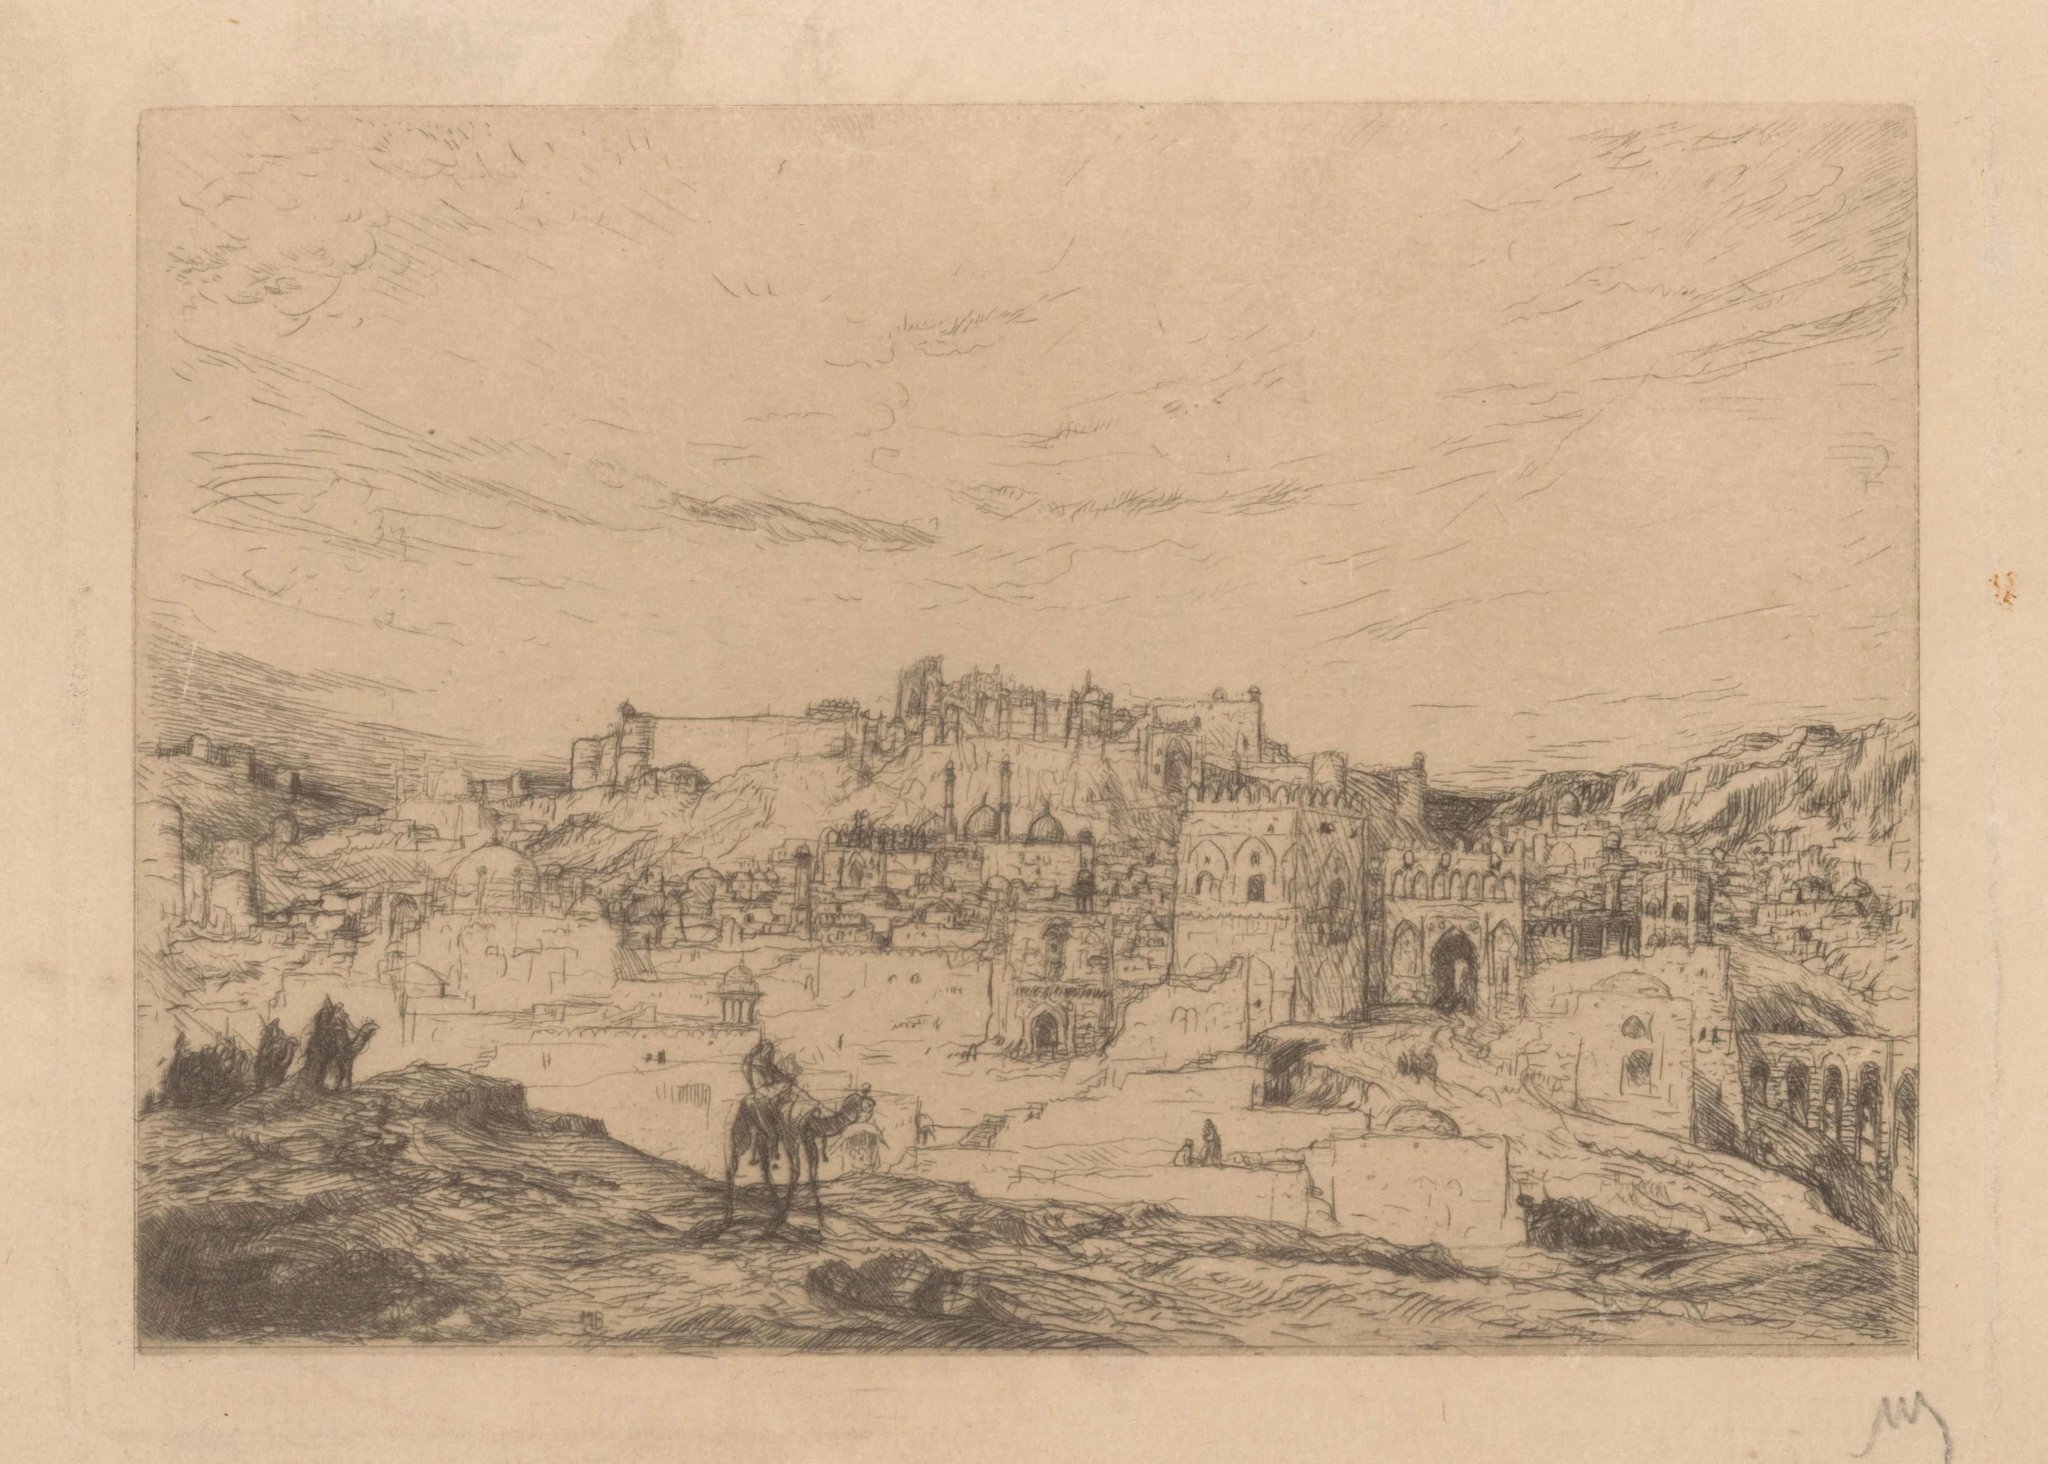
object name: print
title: Oosterse stad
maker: marius bauer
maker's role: draughtsman, print maker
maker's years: 1867-1932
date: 1898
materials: paper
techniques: etching, intaglio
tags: hoofed animals: camel, city-view in general; 'veduta'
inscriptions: collector's mark: Lugt 2228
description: Stadsgezicht op een stad met burcht en verschillende moskeeën. Op de voorgrond enkele kamelen en hun berijders.